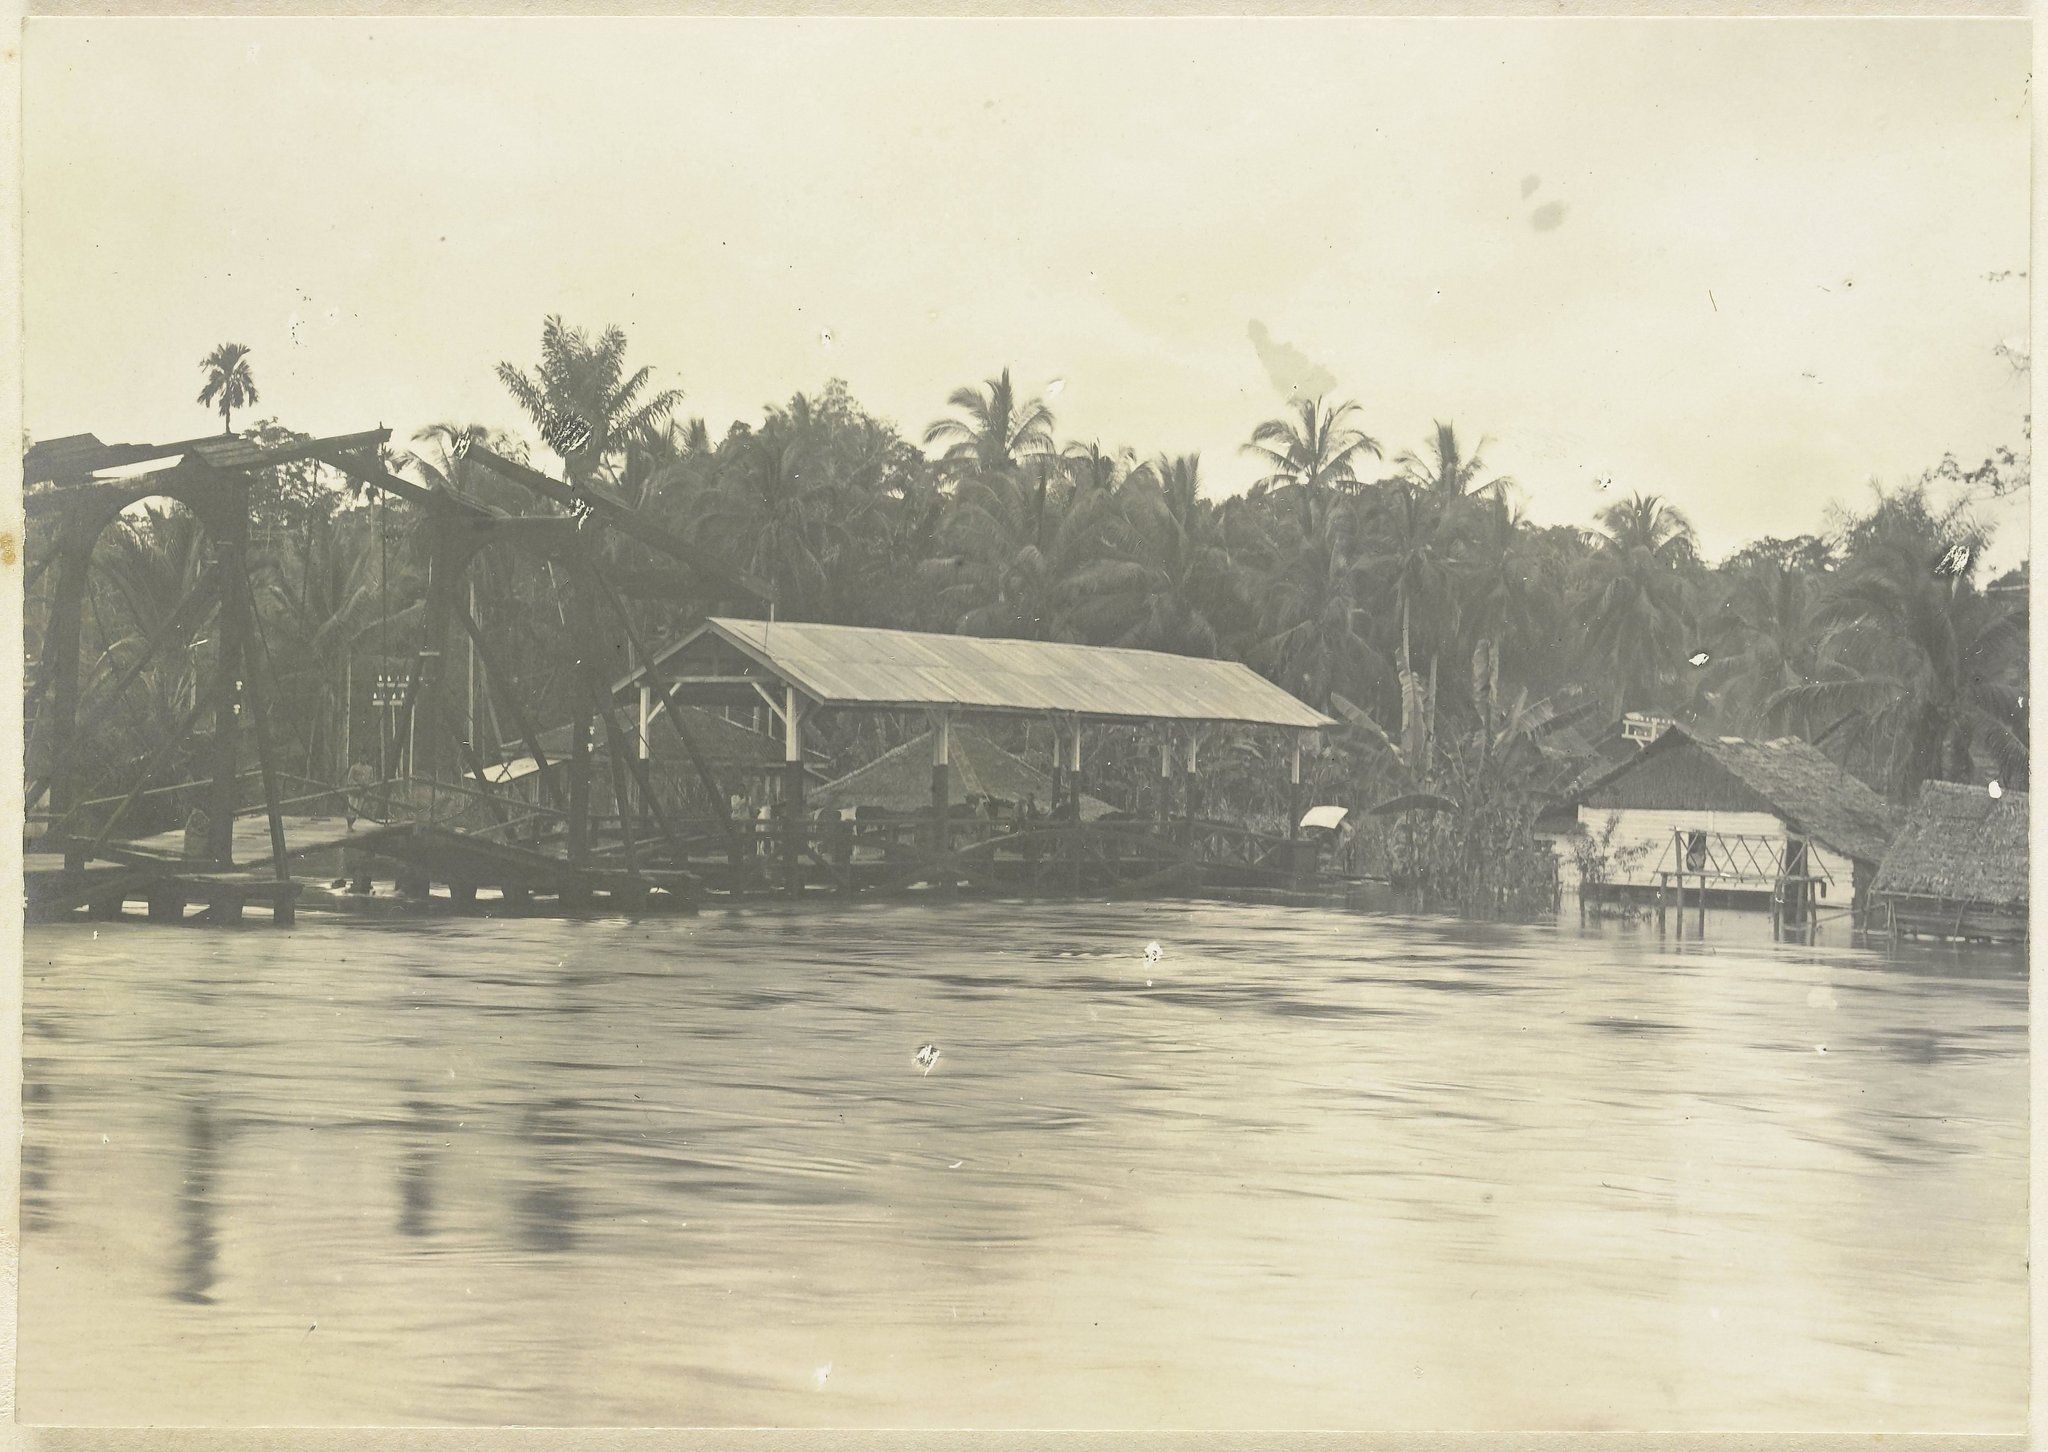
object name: photograph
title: Hoog water op Wampoerivier bij de Sandelbrug, Tandjong Poera, Langkat Sumatra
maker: Anonymous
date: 1900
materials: cardboard, paper, photographic support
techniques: gelatin silver print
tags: sumatra